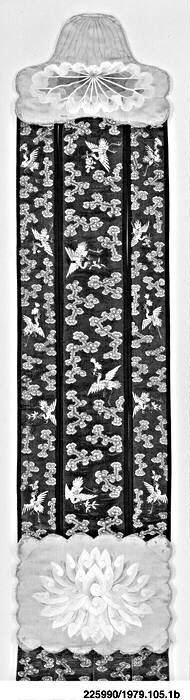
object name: temple banner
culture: chinese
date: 1801-1900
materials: cardboard, cotton, silk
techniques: backing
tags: birds,flags